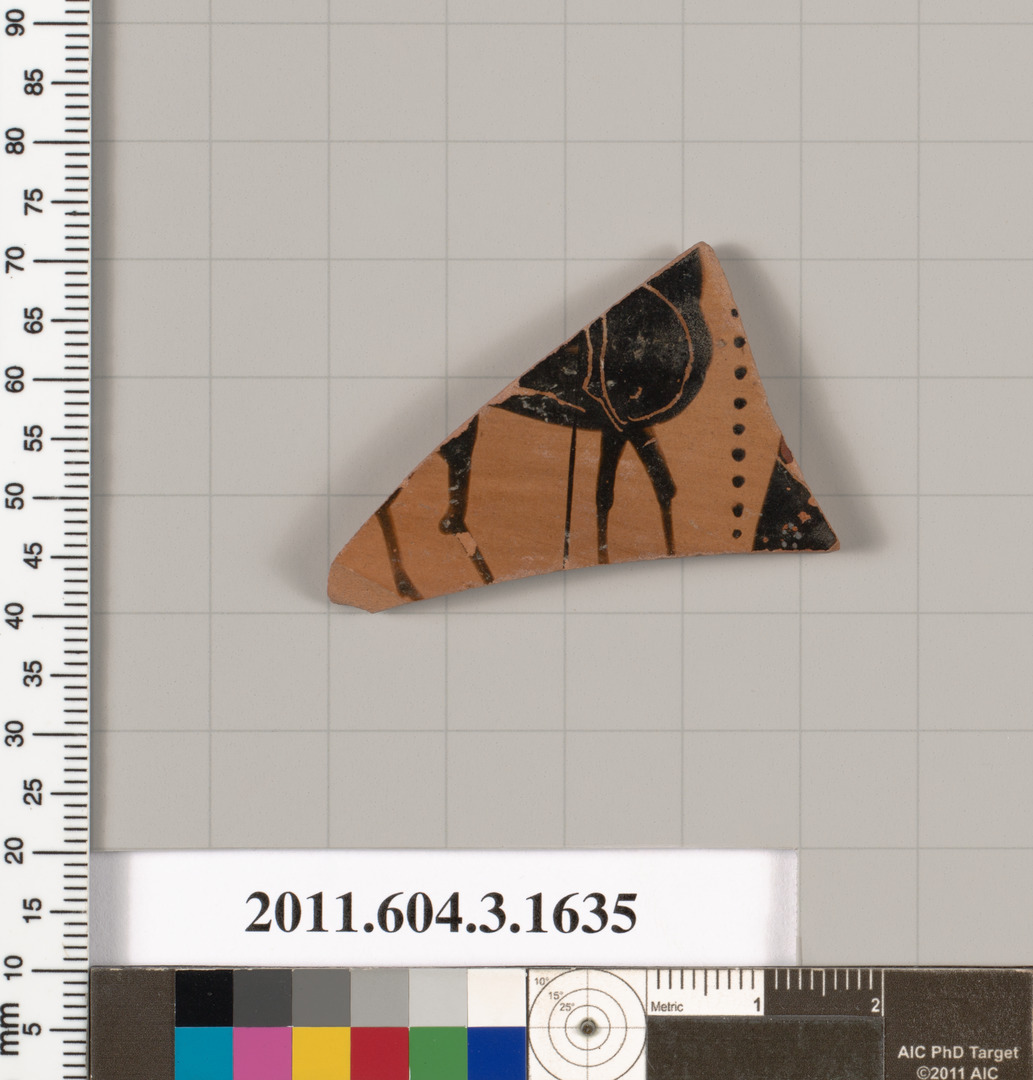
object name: kylix fragment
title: Terracotta fragment of a kylix: Band cup (drinking cup)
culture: greek, attic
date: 550-526 BCE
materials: terracotta